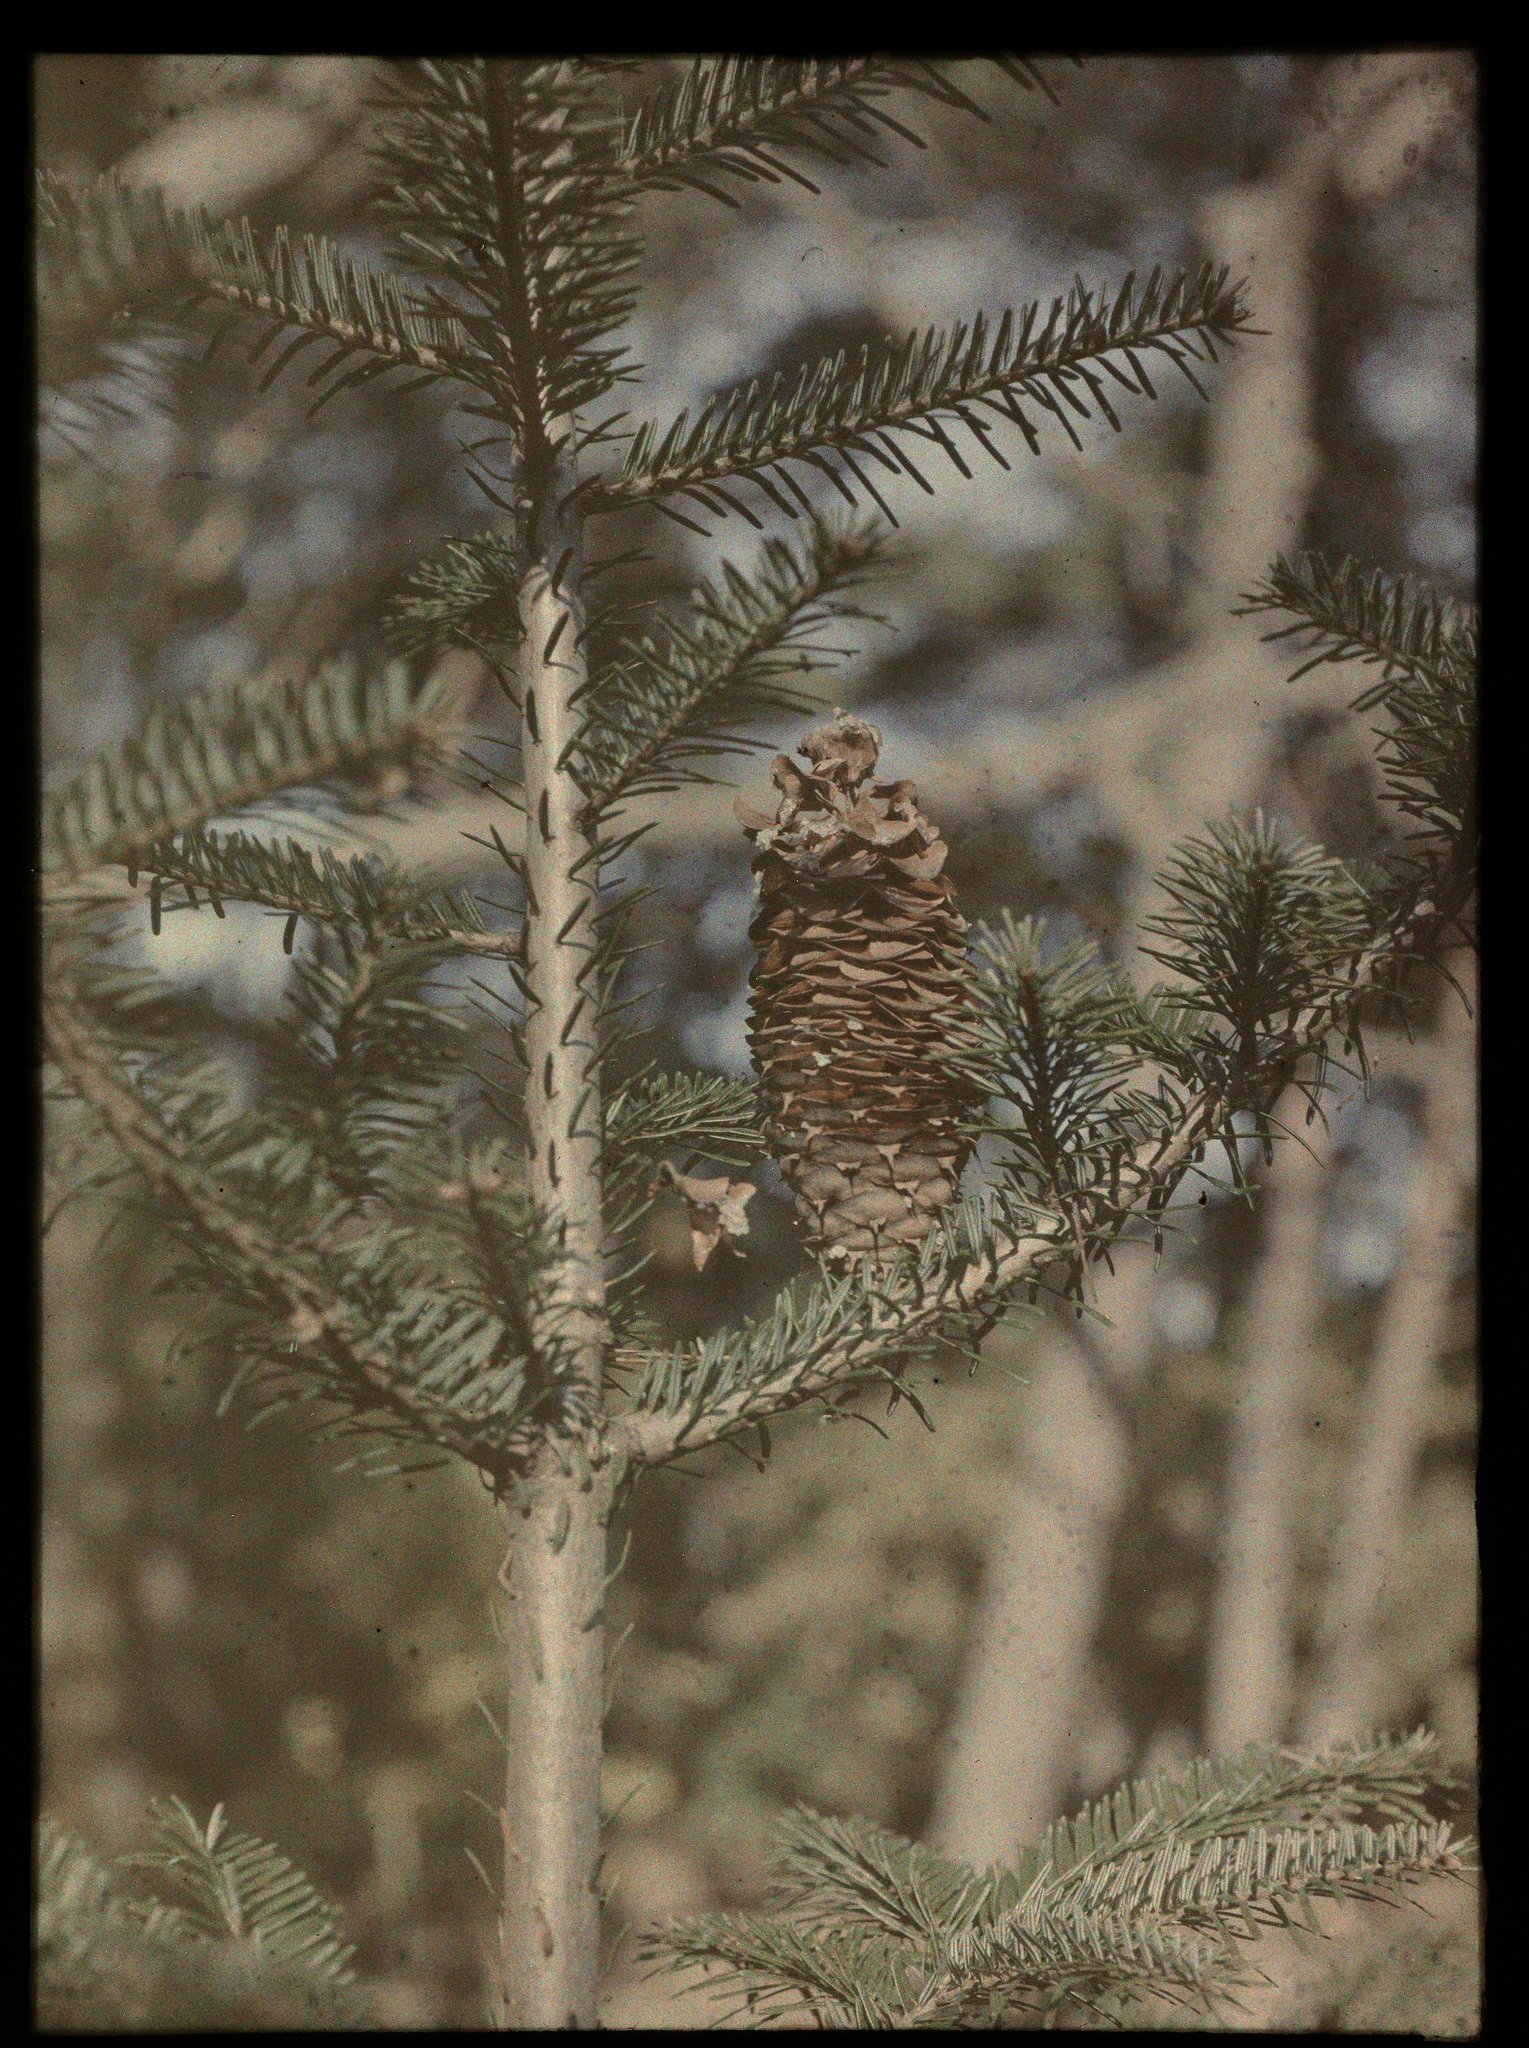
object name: color slide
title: Takken van een naaldboom, met een dennenappel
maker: adolphe burdet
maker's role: fotograaf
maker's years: 1860-1940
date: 1907-1930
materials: glass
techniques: autochrome process, slide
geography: netherlands